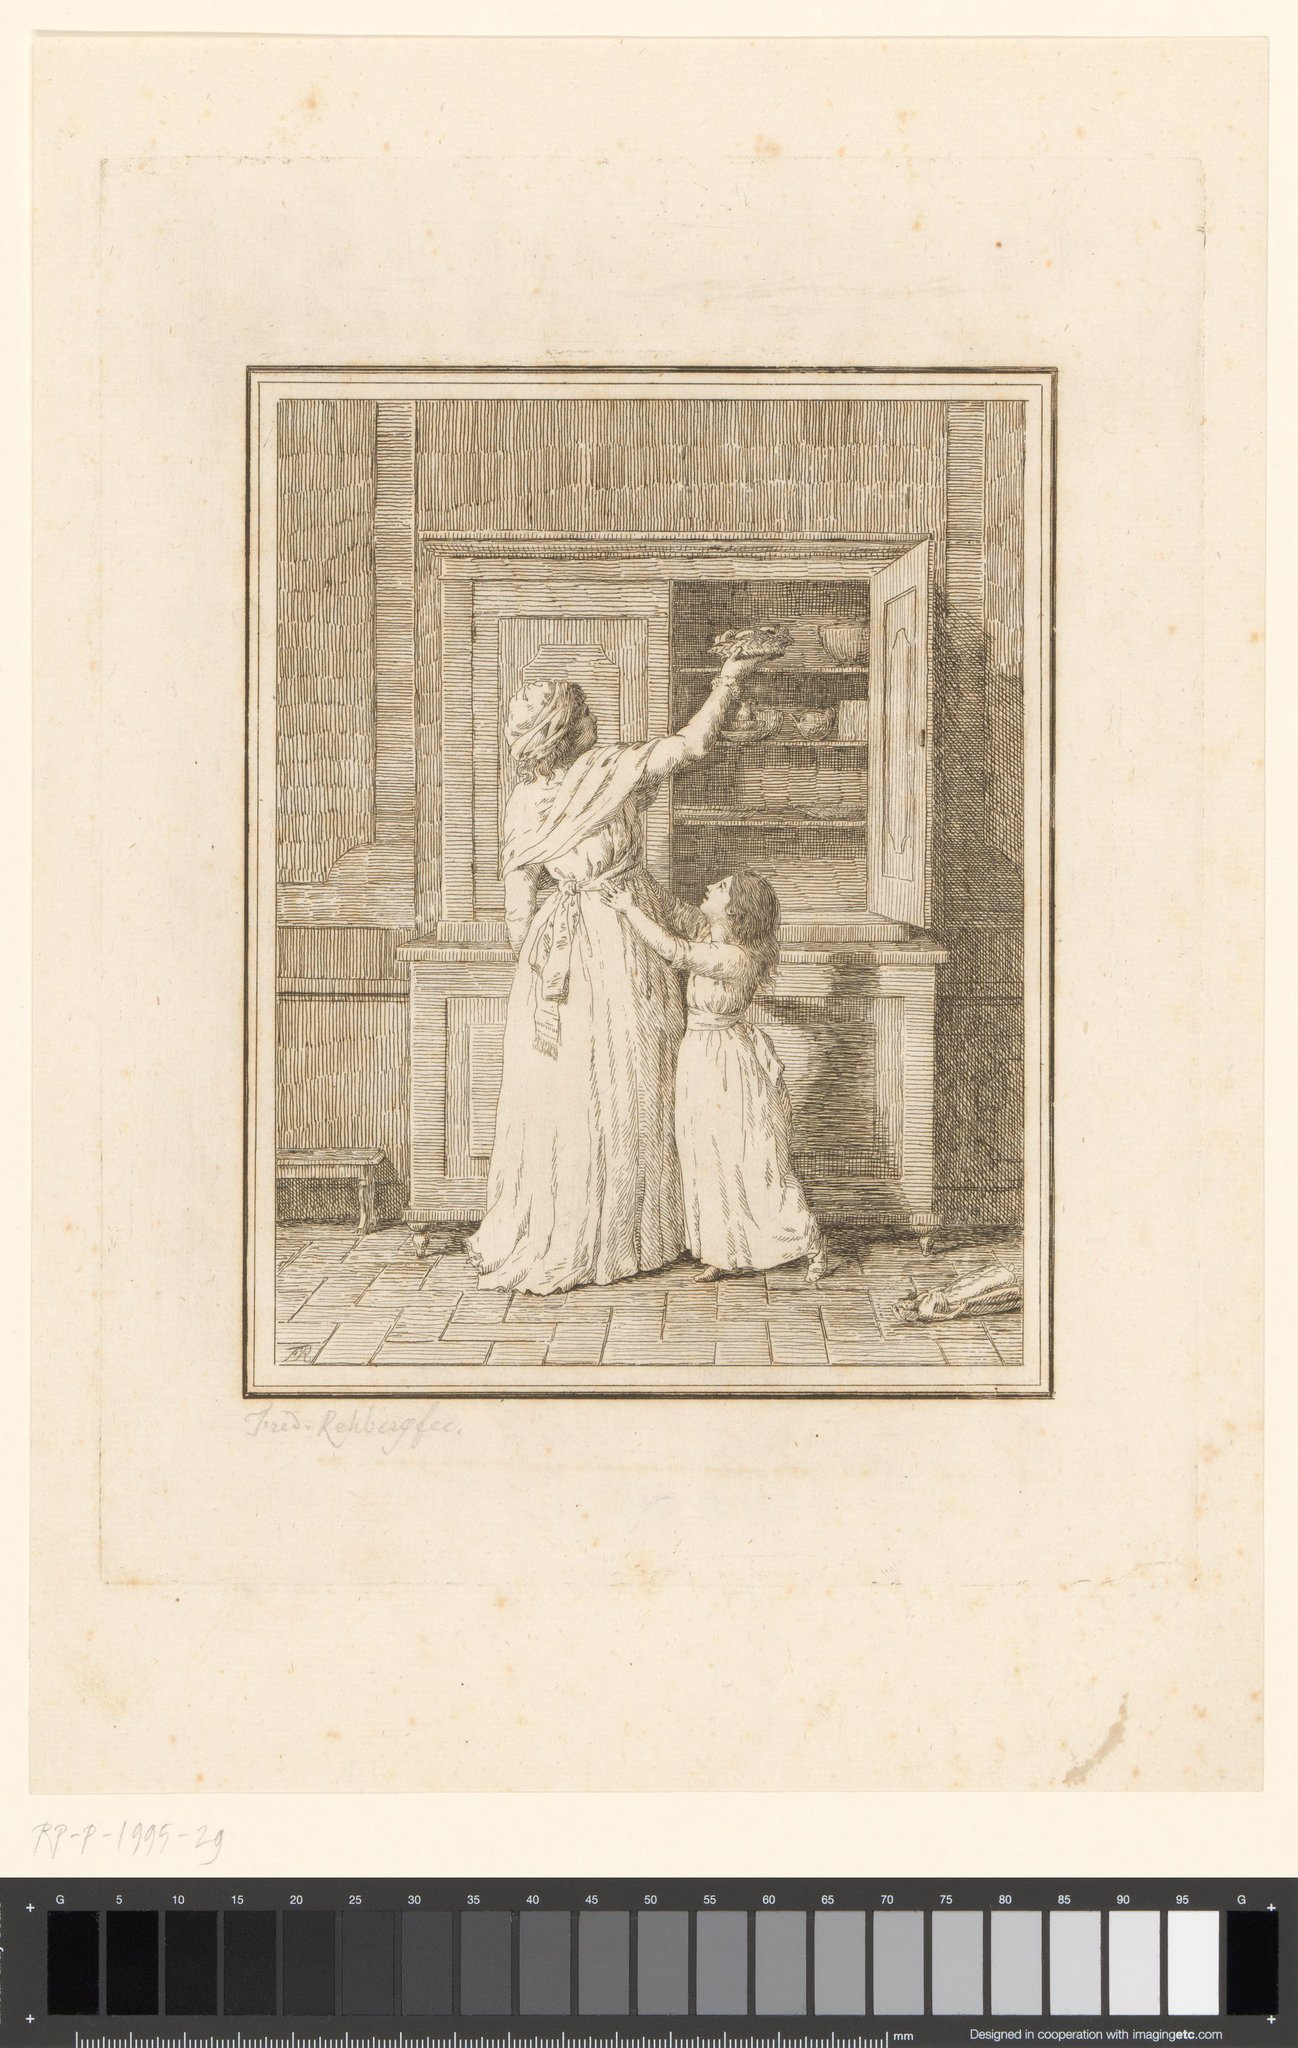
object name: print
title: Figure prese dal vero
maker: friedrich rehberg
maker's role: print maker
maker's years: 1785-1835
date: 1793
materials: paper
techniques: etching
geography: rome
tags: housewife, cupboard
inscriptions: collector's mark: Lugt 2228, name: ‘Fred. Rehberg fec.’ Lugt, collector's mark: Lugt 2760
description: Prent uit de serie "Figure prese dal vero", 6 bladen.